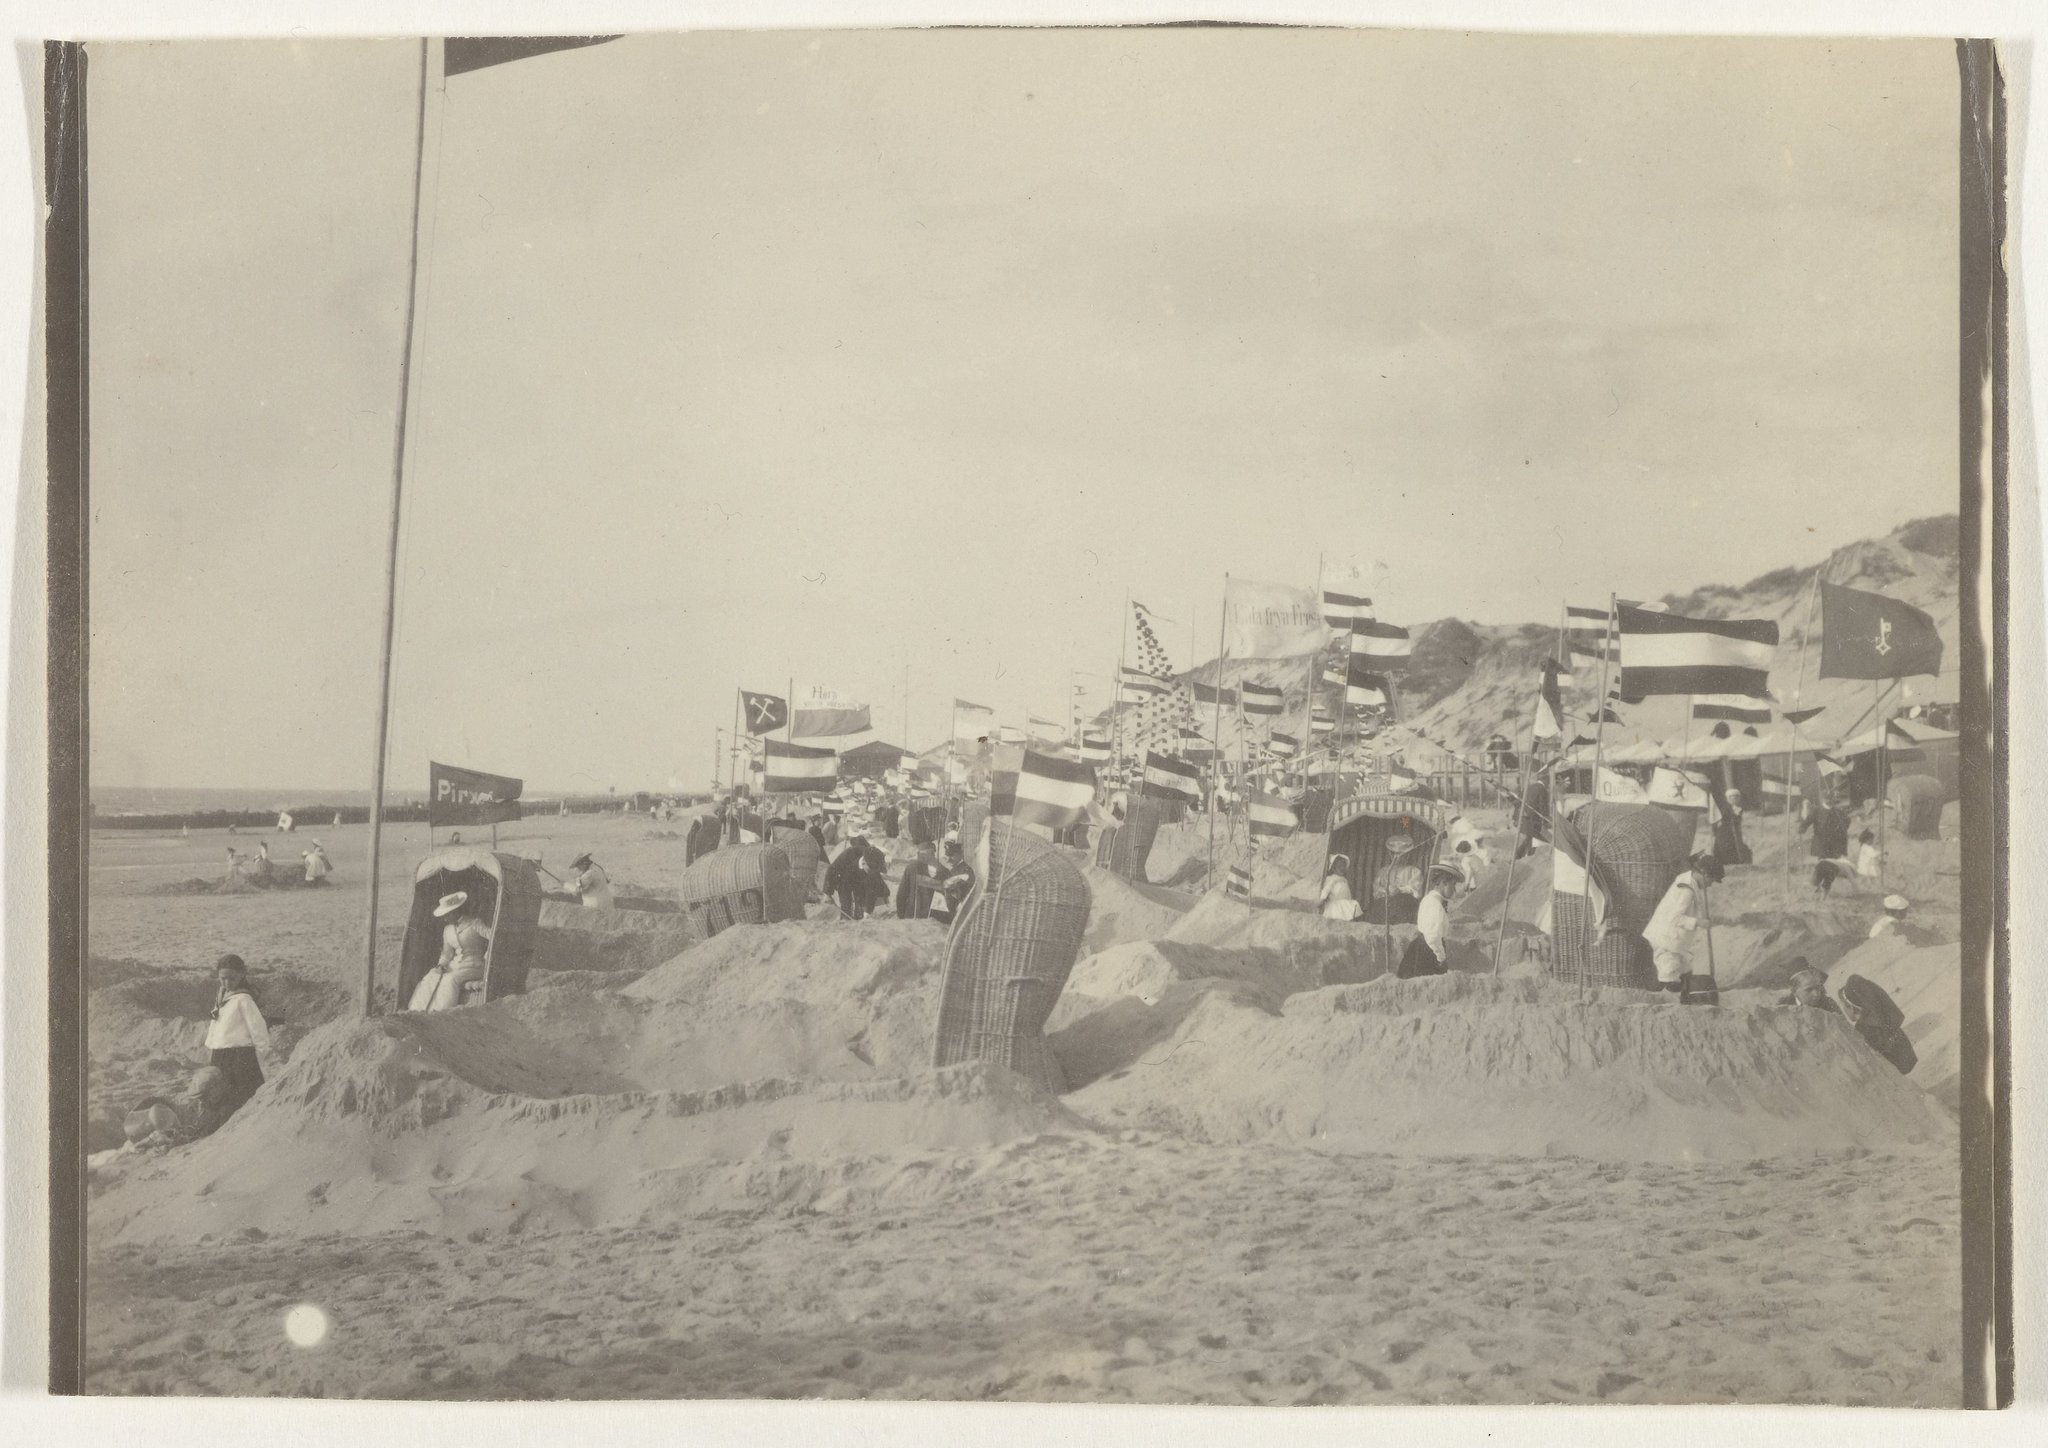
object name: photograph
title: Aan het strand (Noordzeekust), Duitsland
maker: Anonymous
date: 1900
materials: paper, photographic support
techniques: gelatin silver print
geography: germany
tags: beach (as place of recreation), (building) sand-castle, germany